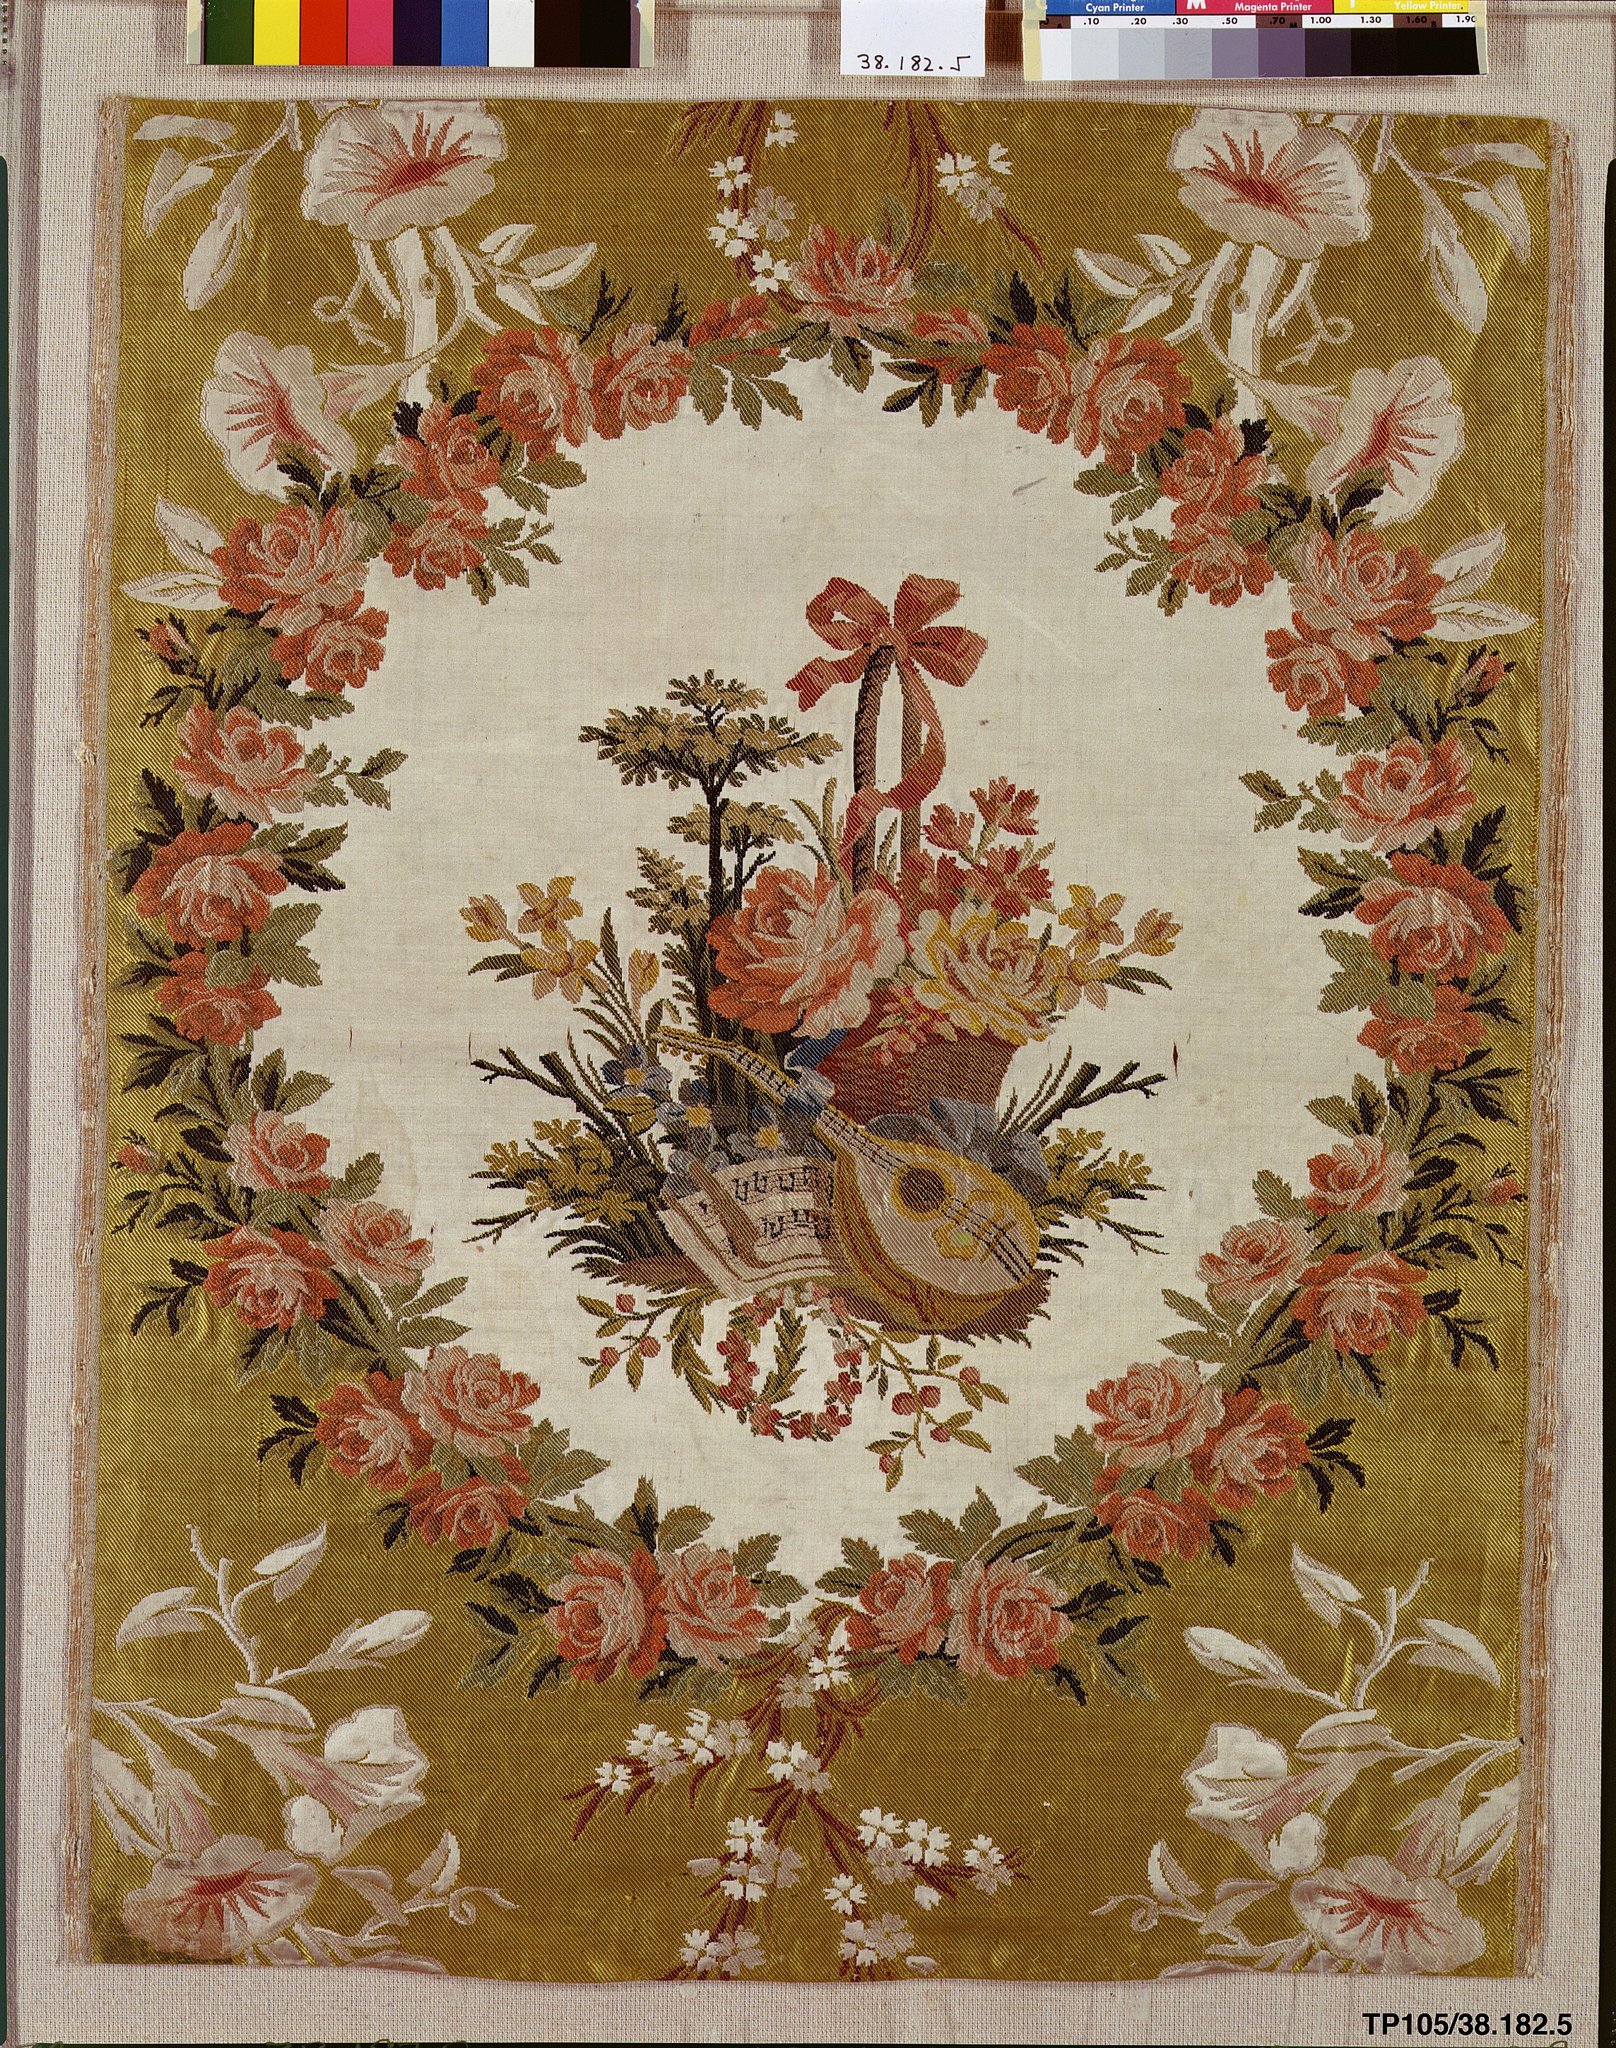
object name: upholstery panel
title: Chair back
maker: philippe de lasalle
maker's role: designer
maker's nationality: french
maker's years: 1723-1804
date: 1770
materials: silk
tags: musical instruments,flowers